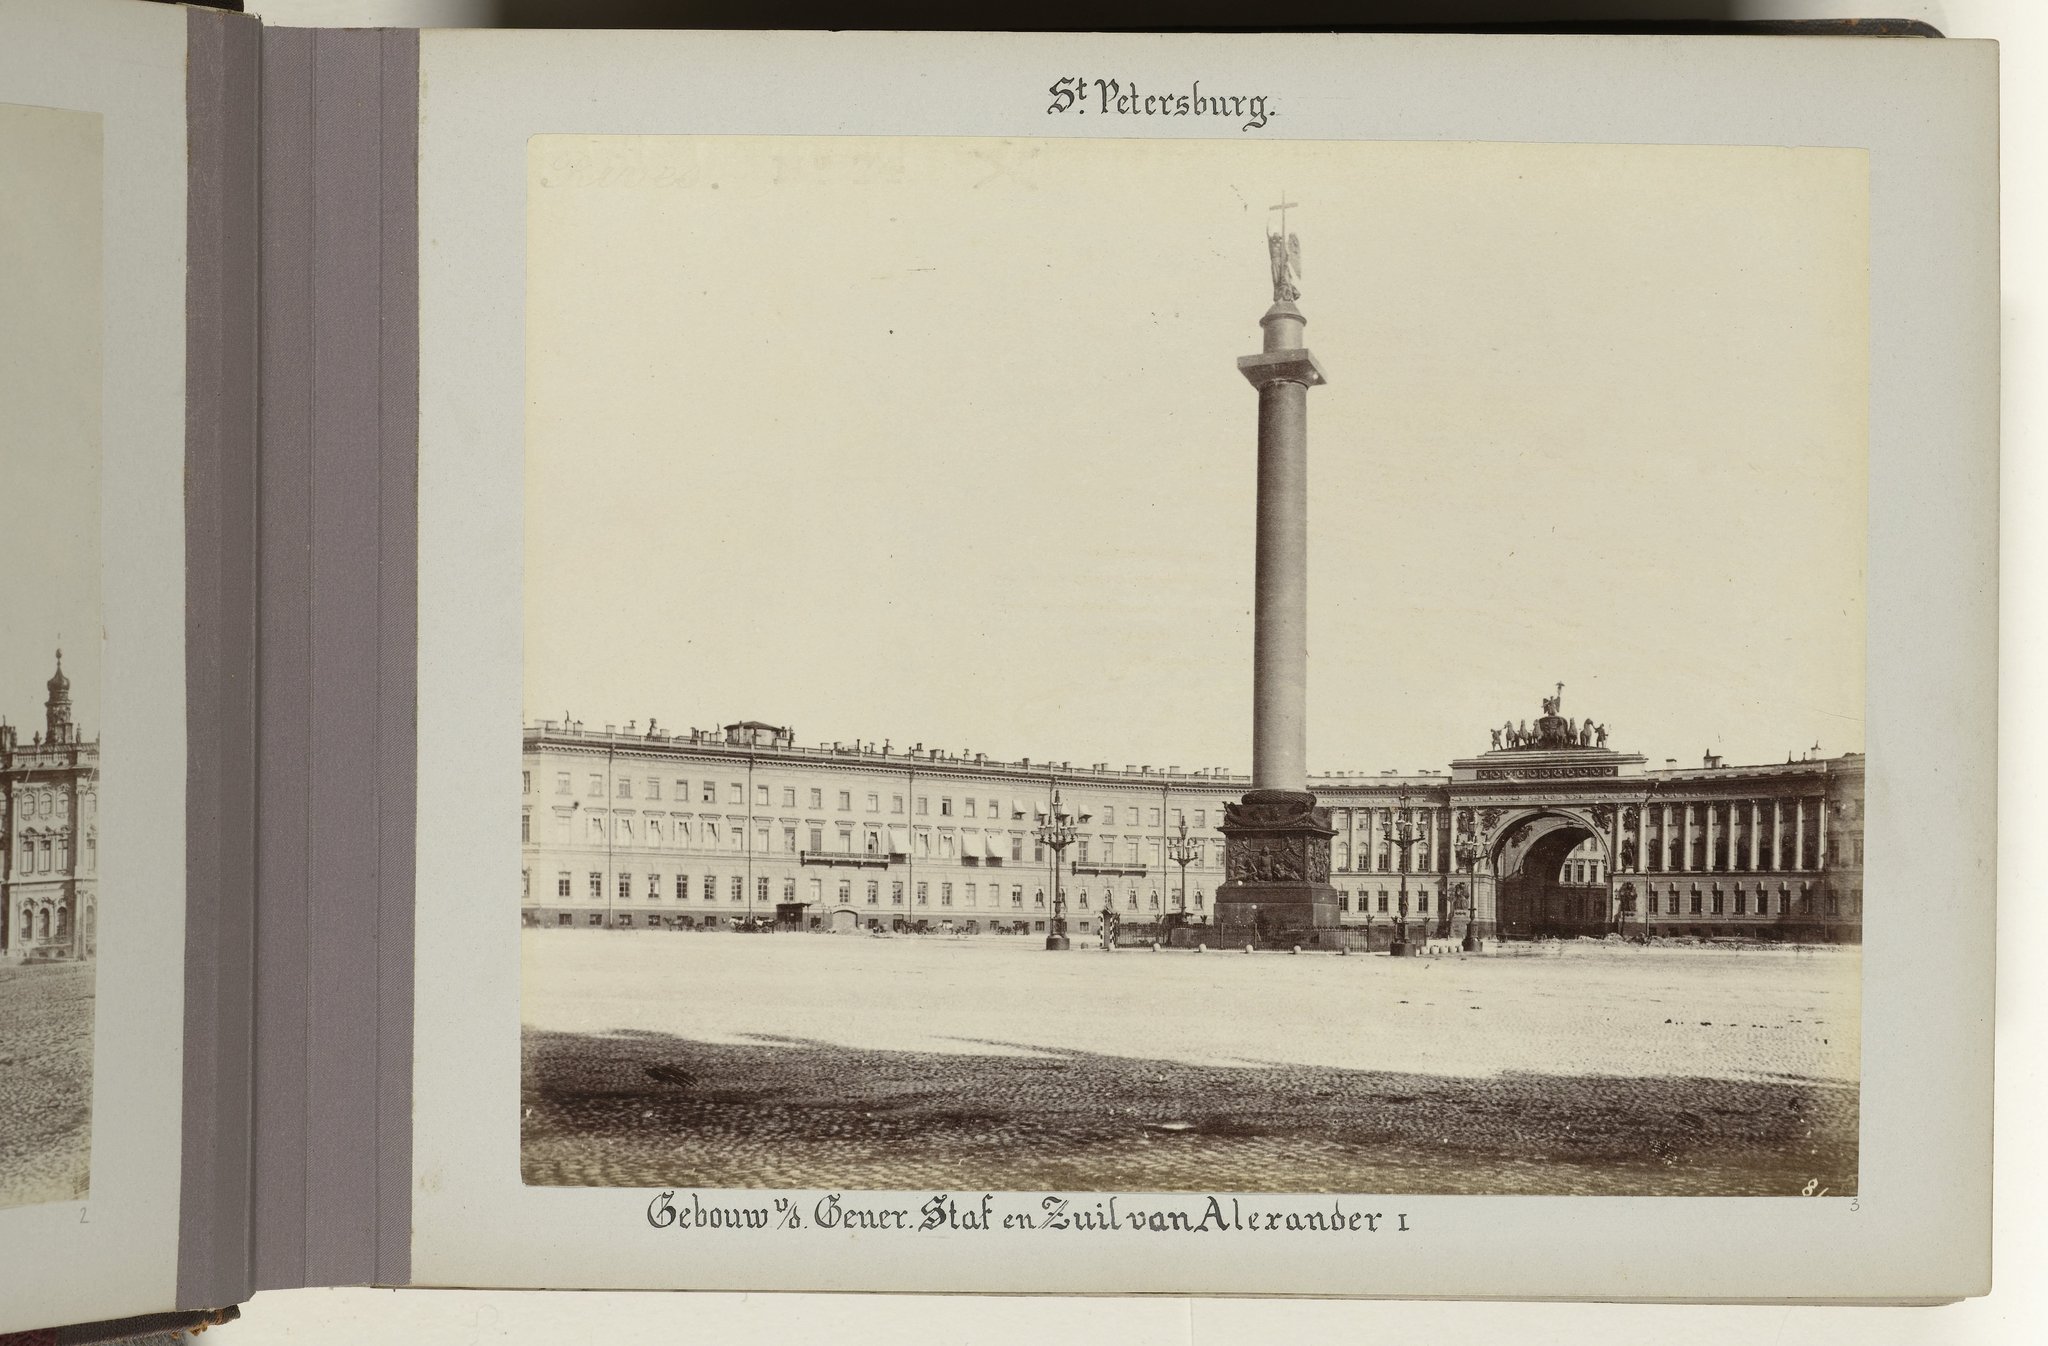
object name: photograph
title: Gebouw van de Generale Staf en de Alexander kolom gebouwd aan de Hermitage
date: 1898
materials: paper, photographic support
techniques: albumen print